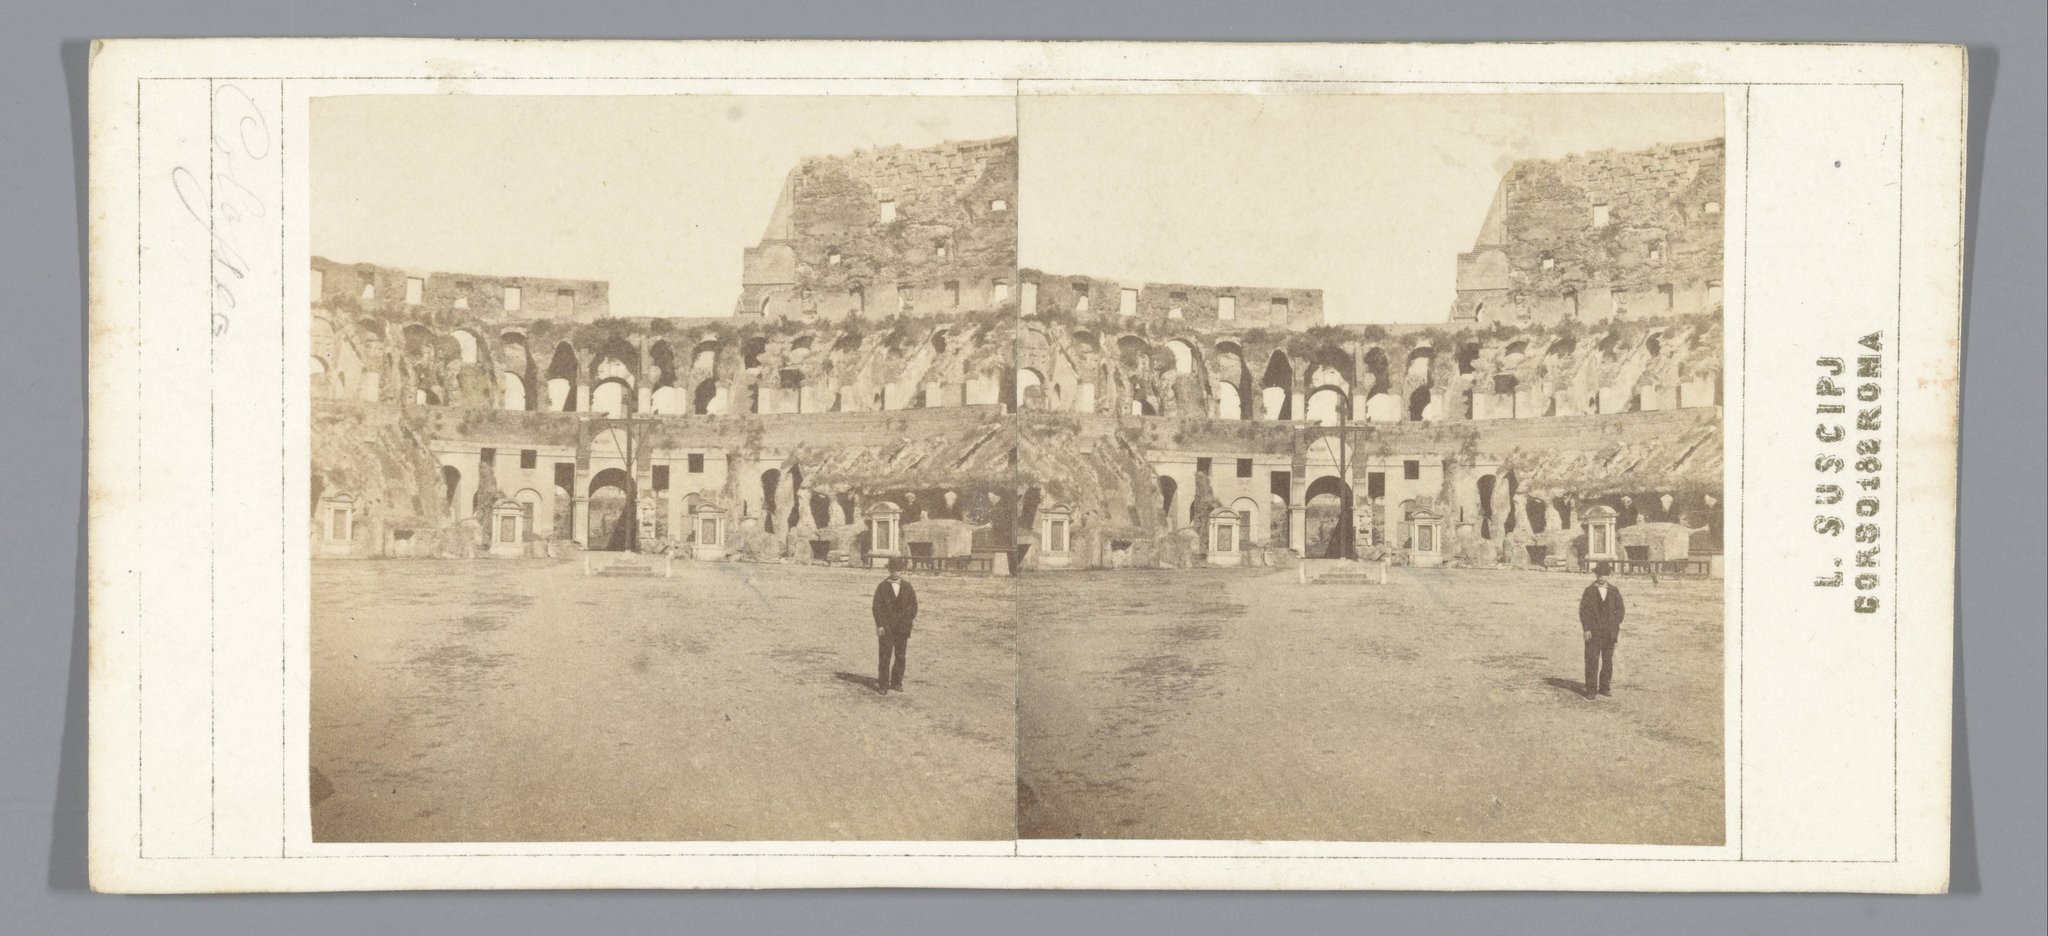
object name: stereograph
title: Colosseo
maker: lorenzo suscipi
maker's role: fotograaf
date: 1850-1880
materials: cardboard, photographic support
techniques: albumen print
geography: colosseum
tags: amphitheatre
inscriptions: number: ‘N: 4’